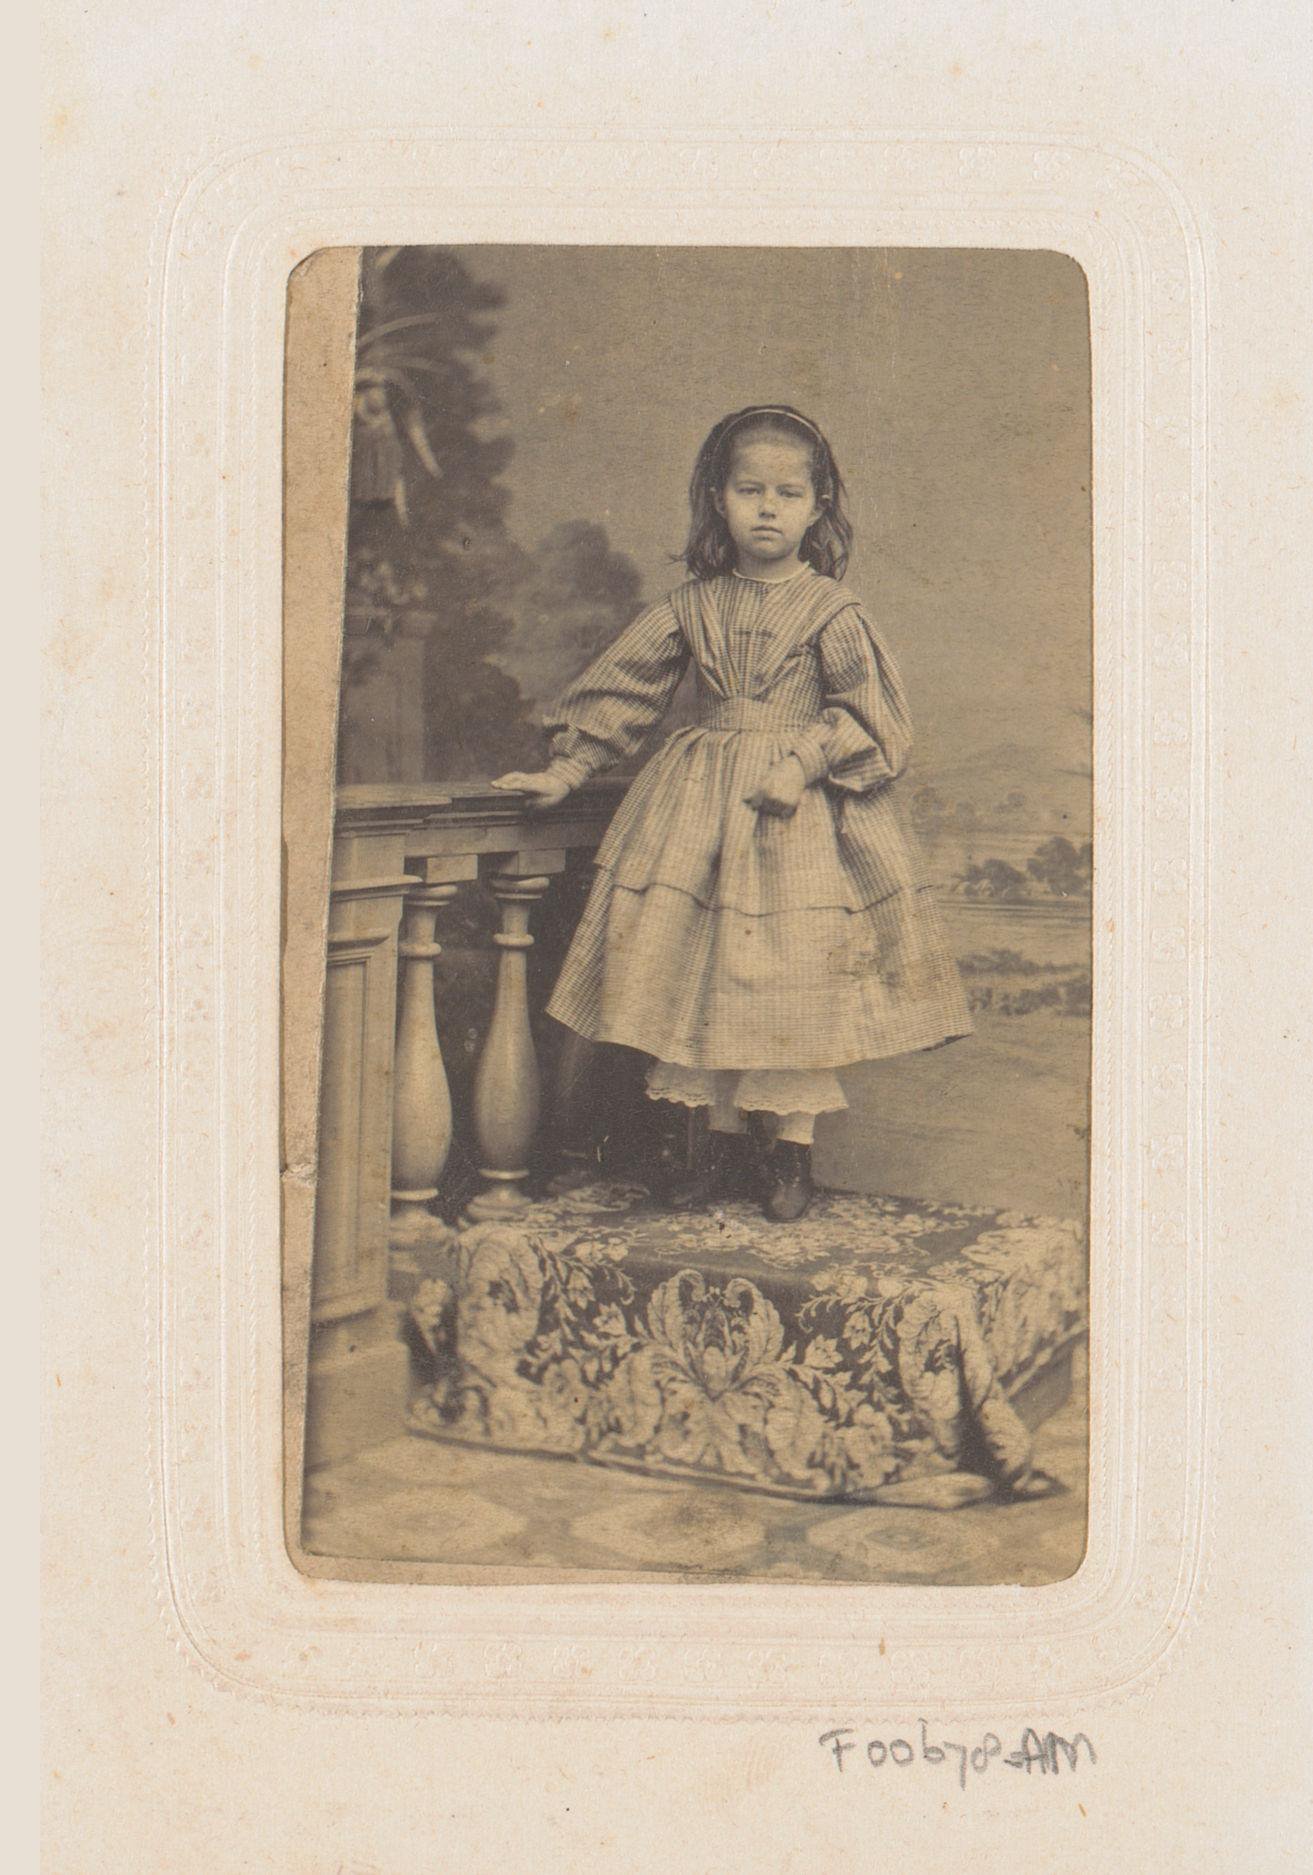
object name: album leaf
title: Portret van een meisje op verhoging bij een balustrade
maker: Anonymous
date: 1860-1880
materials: cardboard, photographic support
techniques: albumen print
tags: historical persons - bb - woman, girl (child between toddler and youth)